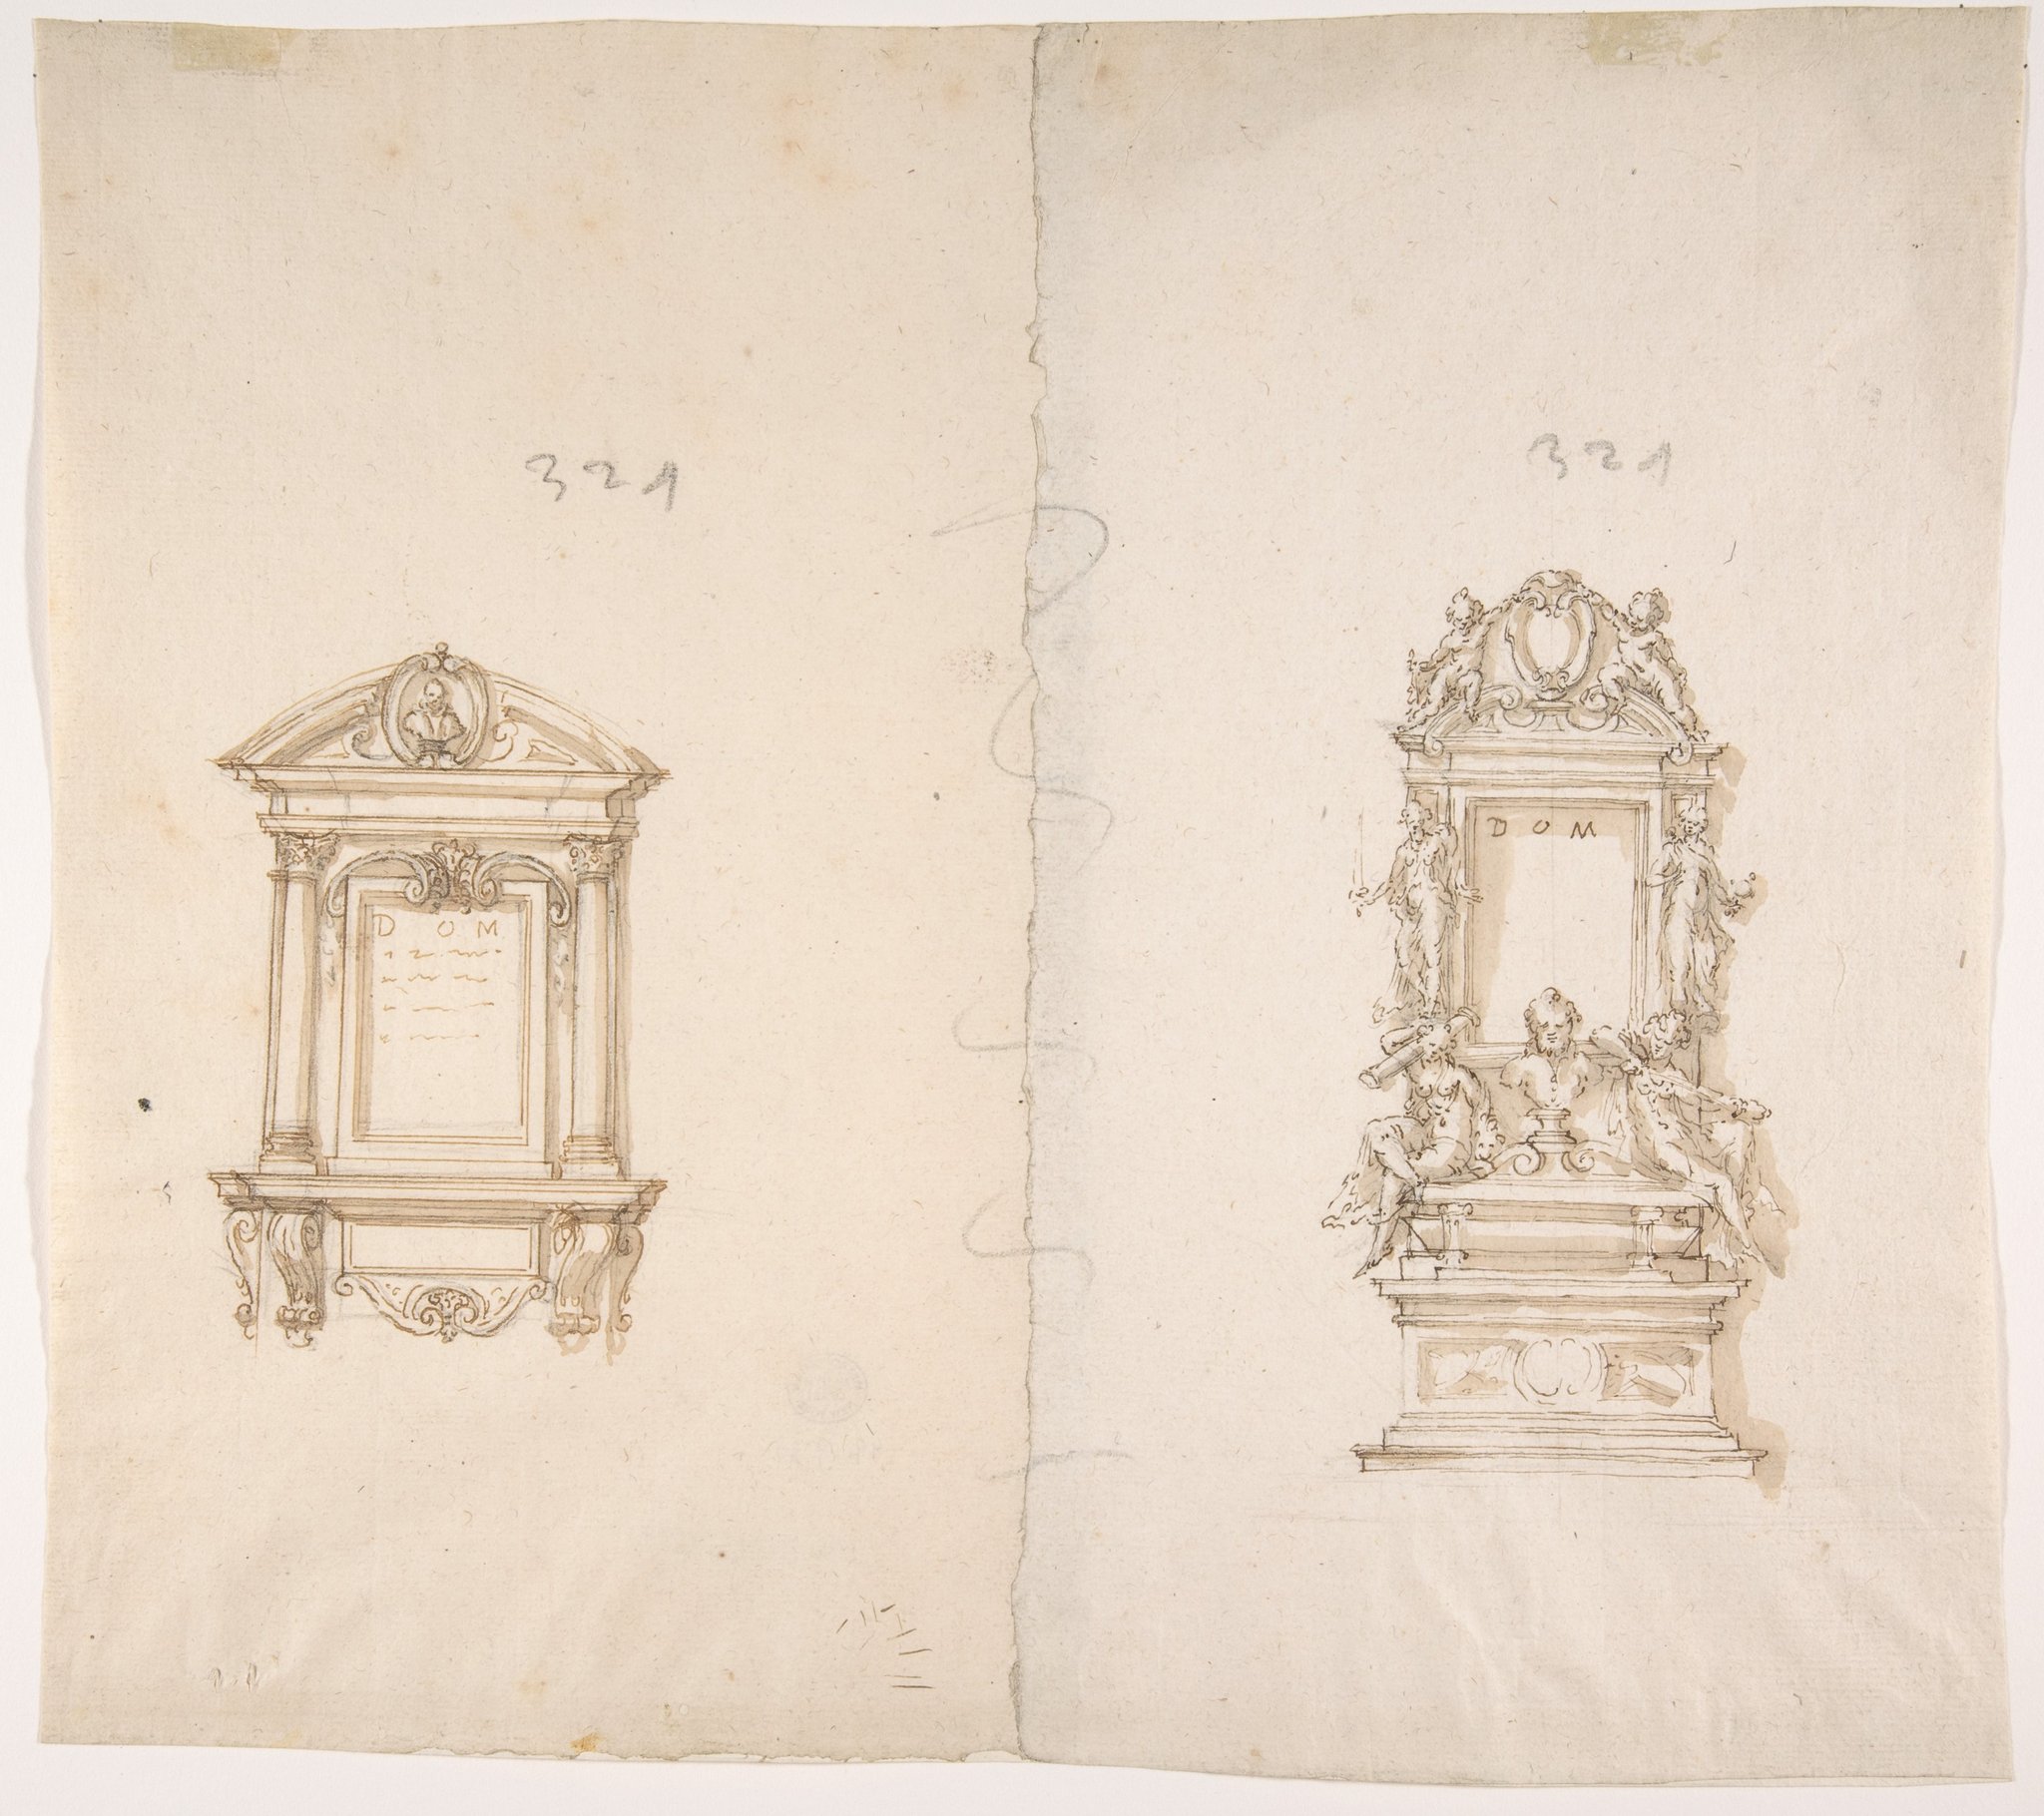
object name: drawing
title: Two Designs for Memorial Tablets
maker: anonymous, french, 16th century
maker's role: artist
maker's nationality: french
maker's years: 1500-1600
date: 1501-1600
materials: chalk, ink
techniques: brush, pen, wash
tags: monuments